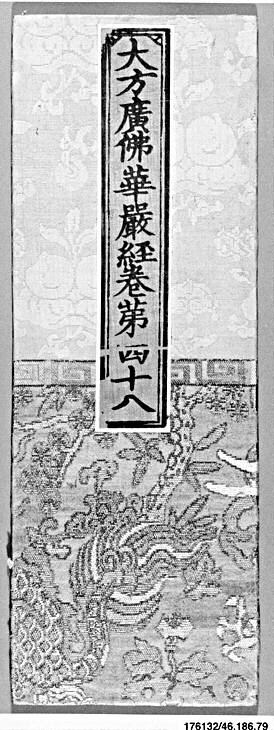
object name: sutra cover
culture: chinese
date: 1601-1700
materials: metal thread, silk